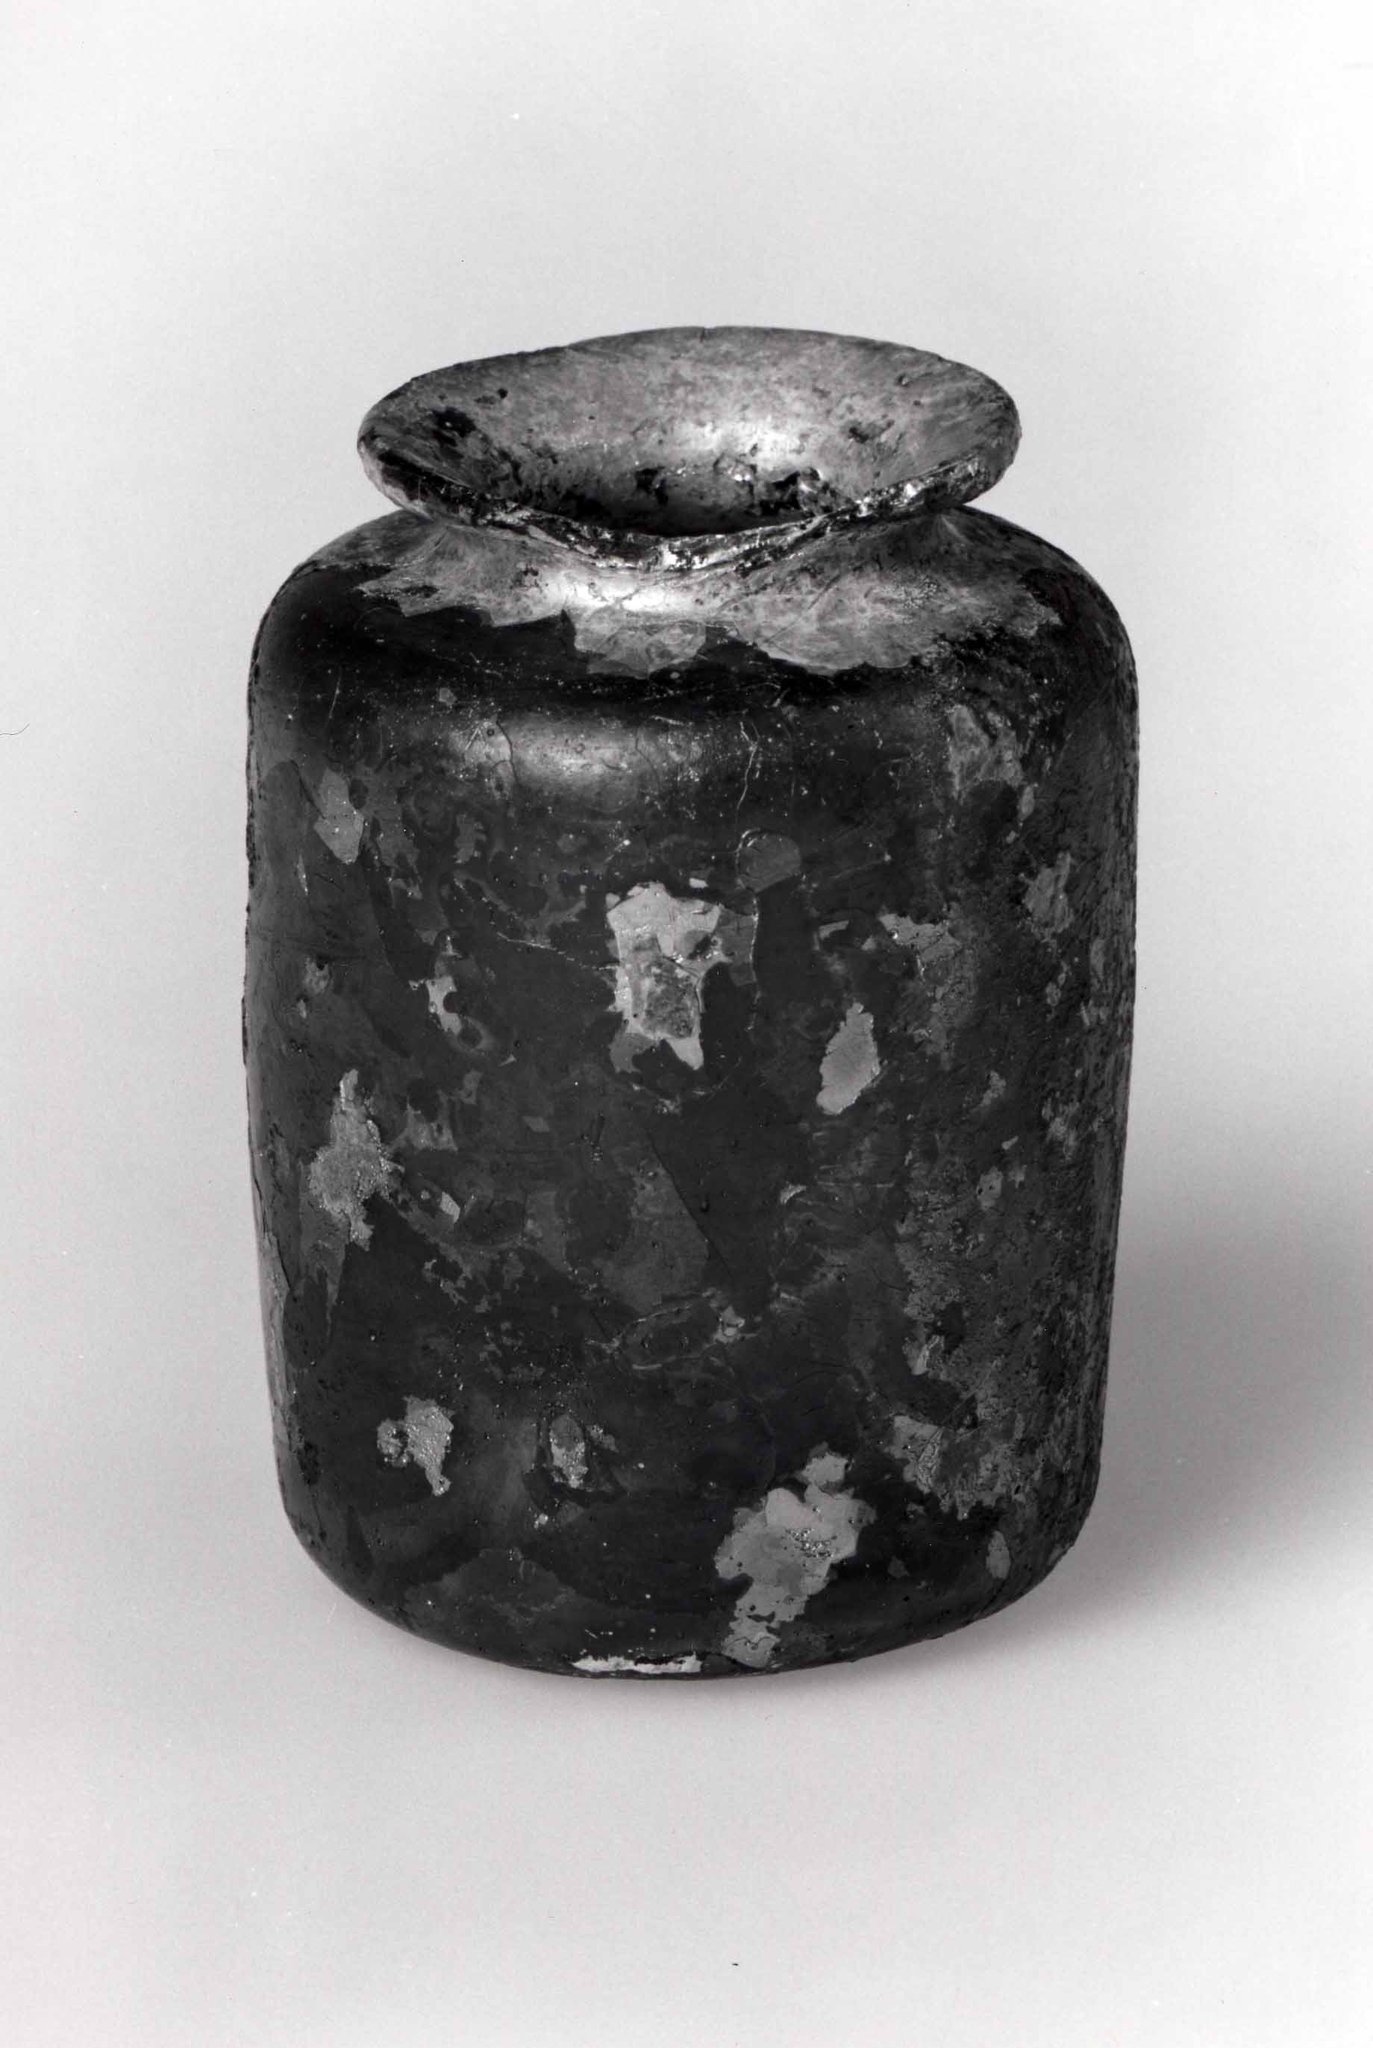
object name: jar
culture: roman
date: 101-400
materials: glass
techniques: glassblowing